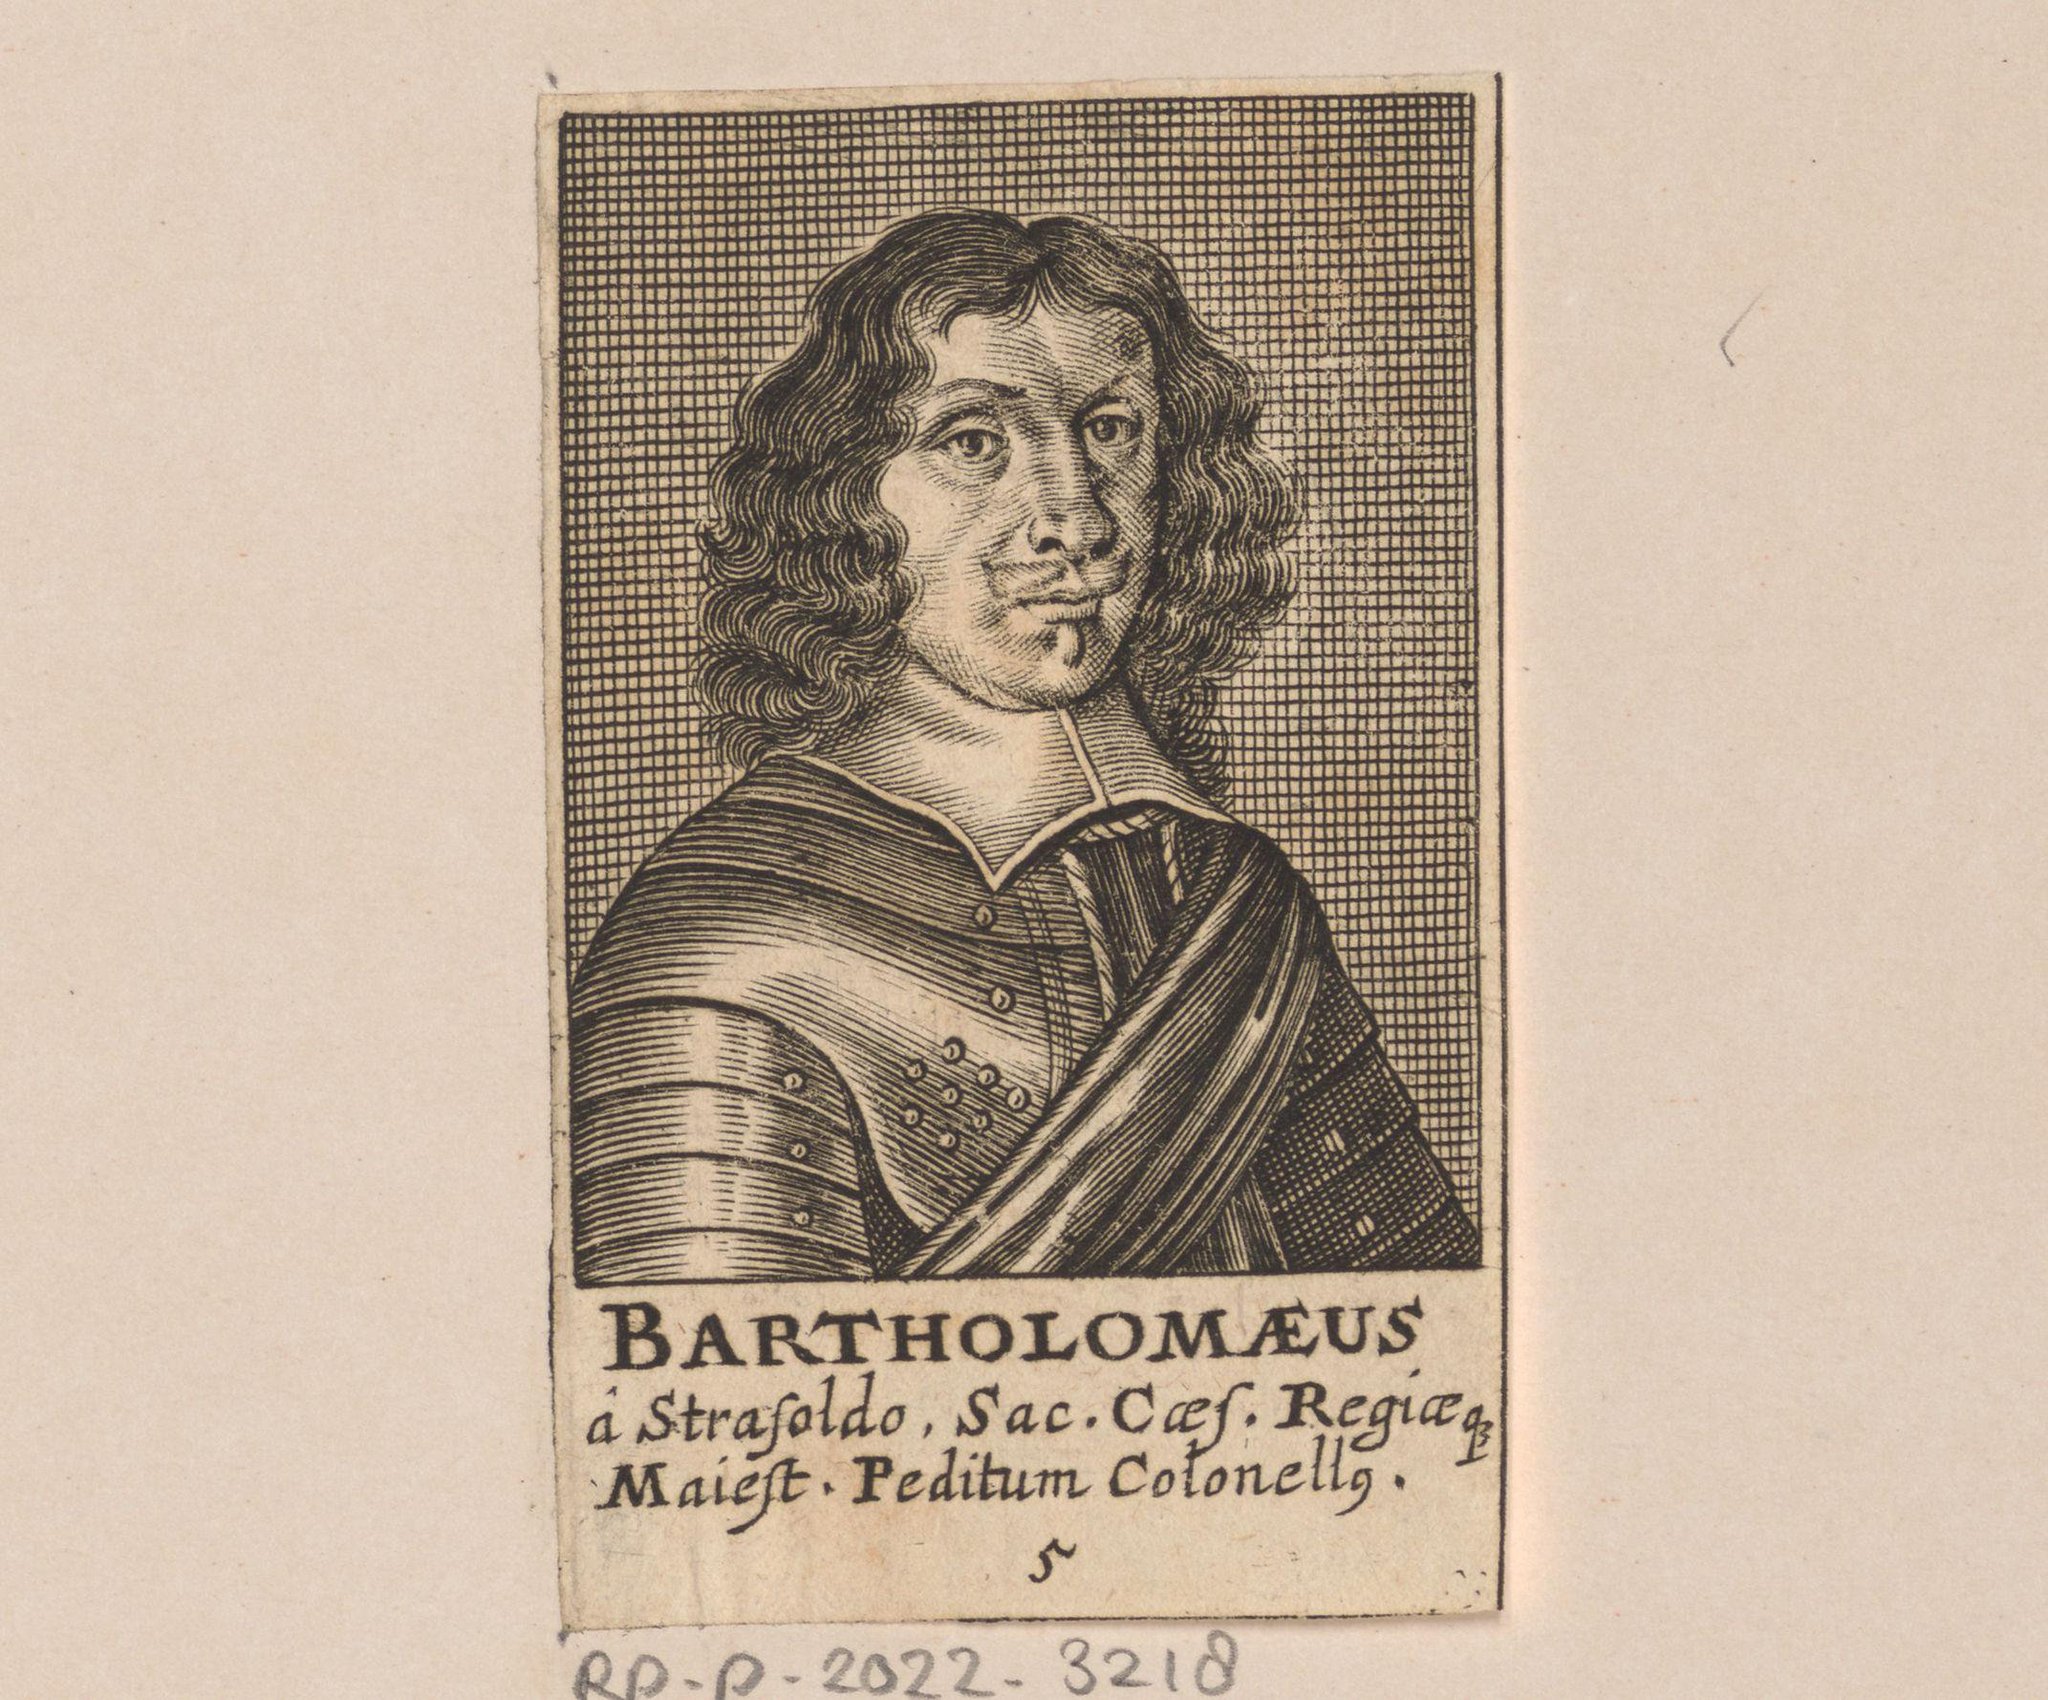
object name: print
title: Portret van Bartholomeus Strasoldo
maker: matthias van sommer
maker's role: draughtsman, print maker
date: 1665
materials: paper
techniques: engraving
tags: commander-in-chief, general, marshal, historical persons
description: Prent uit: Meyer, Martin. Ortelius continuatus Das ist Der Ungarischen Kriegs=Empörungen Fernere Historische Beschreibung (...) Neurenberg: Paul Fürst, 1665.